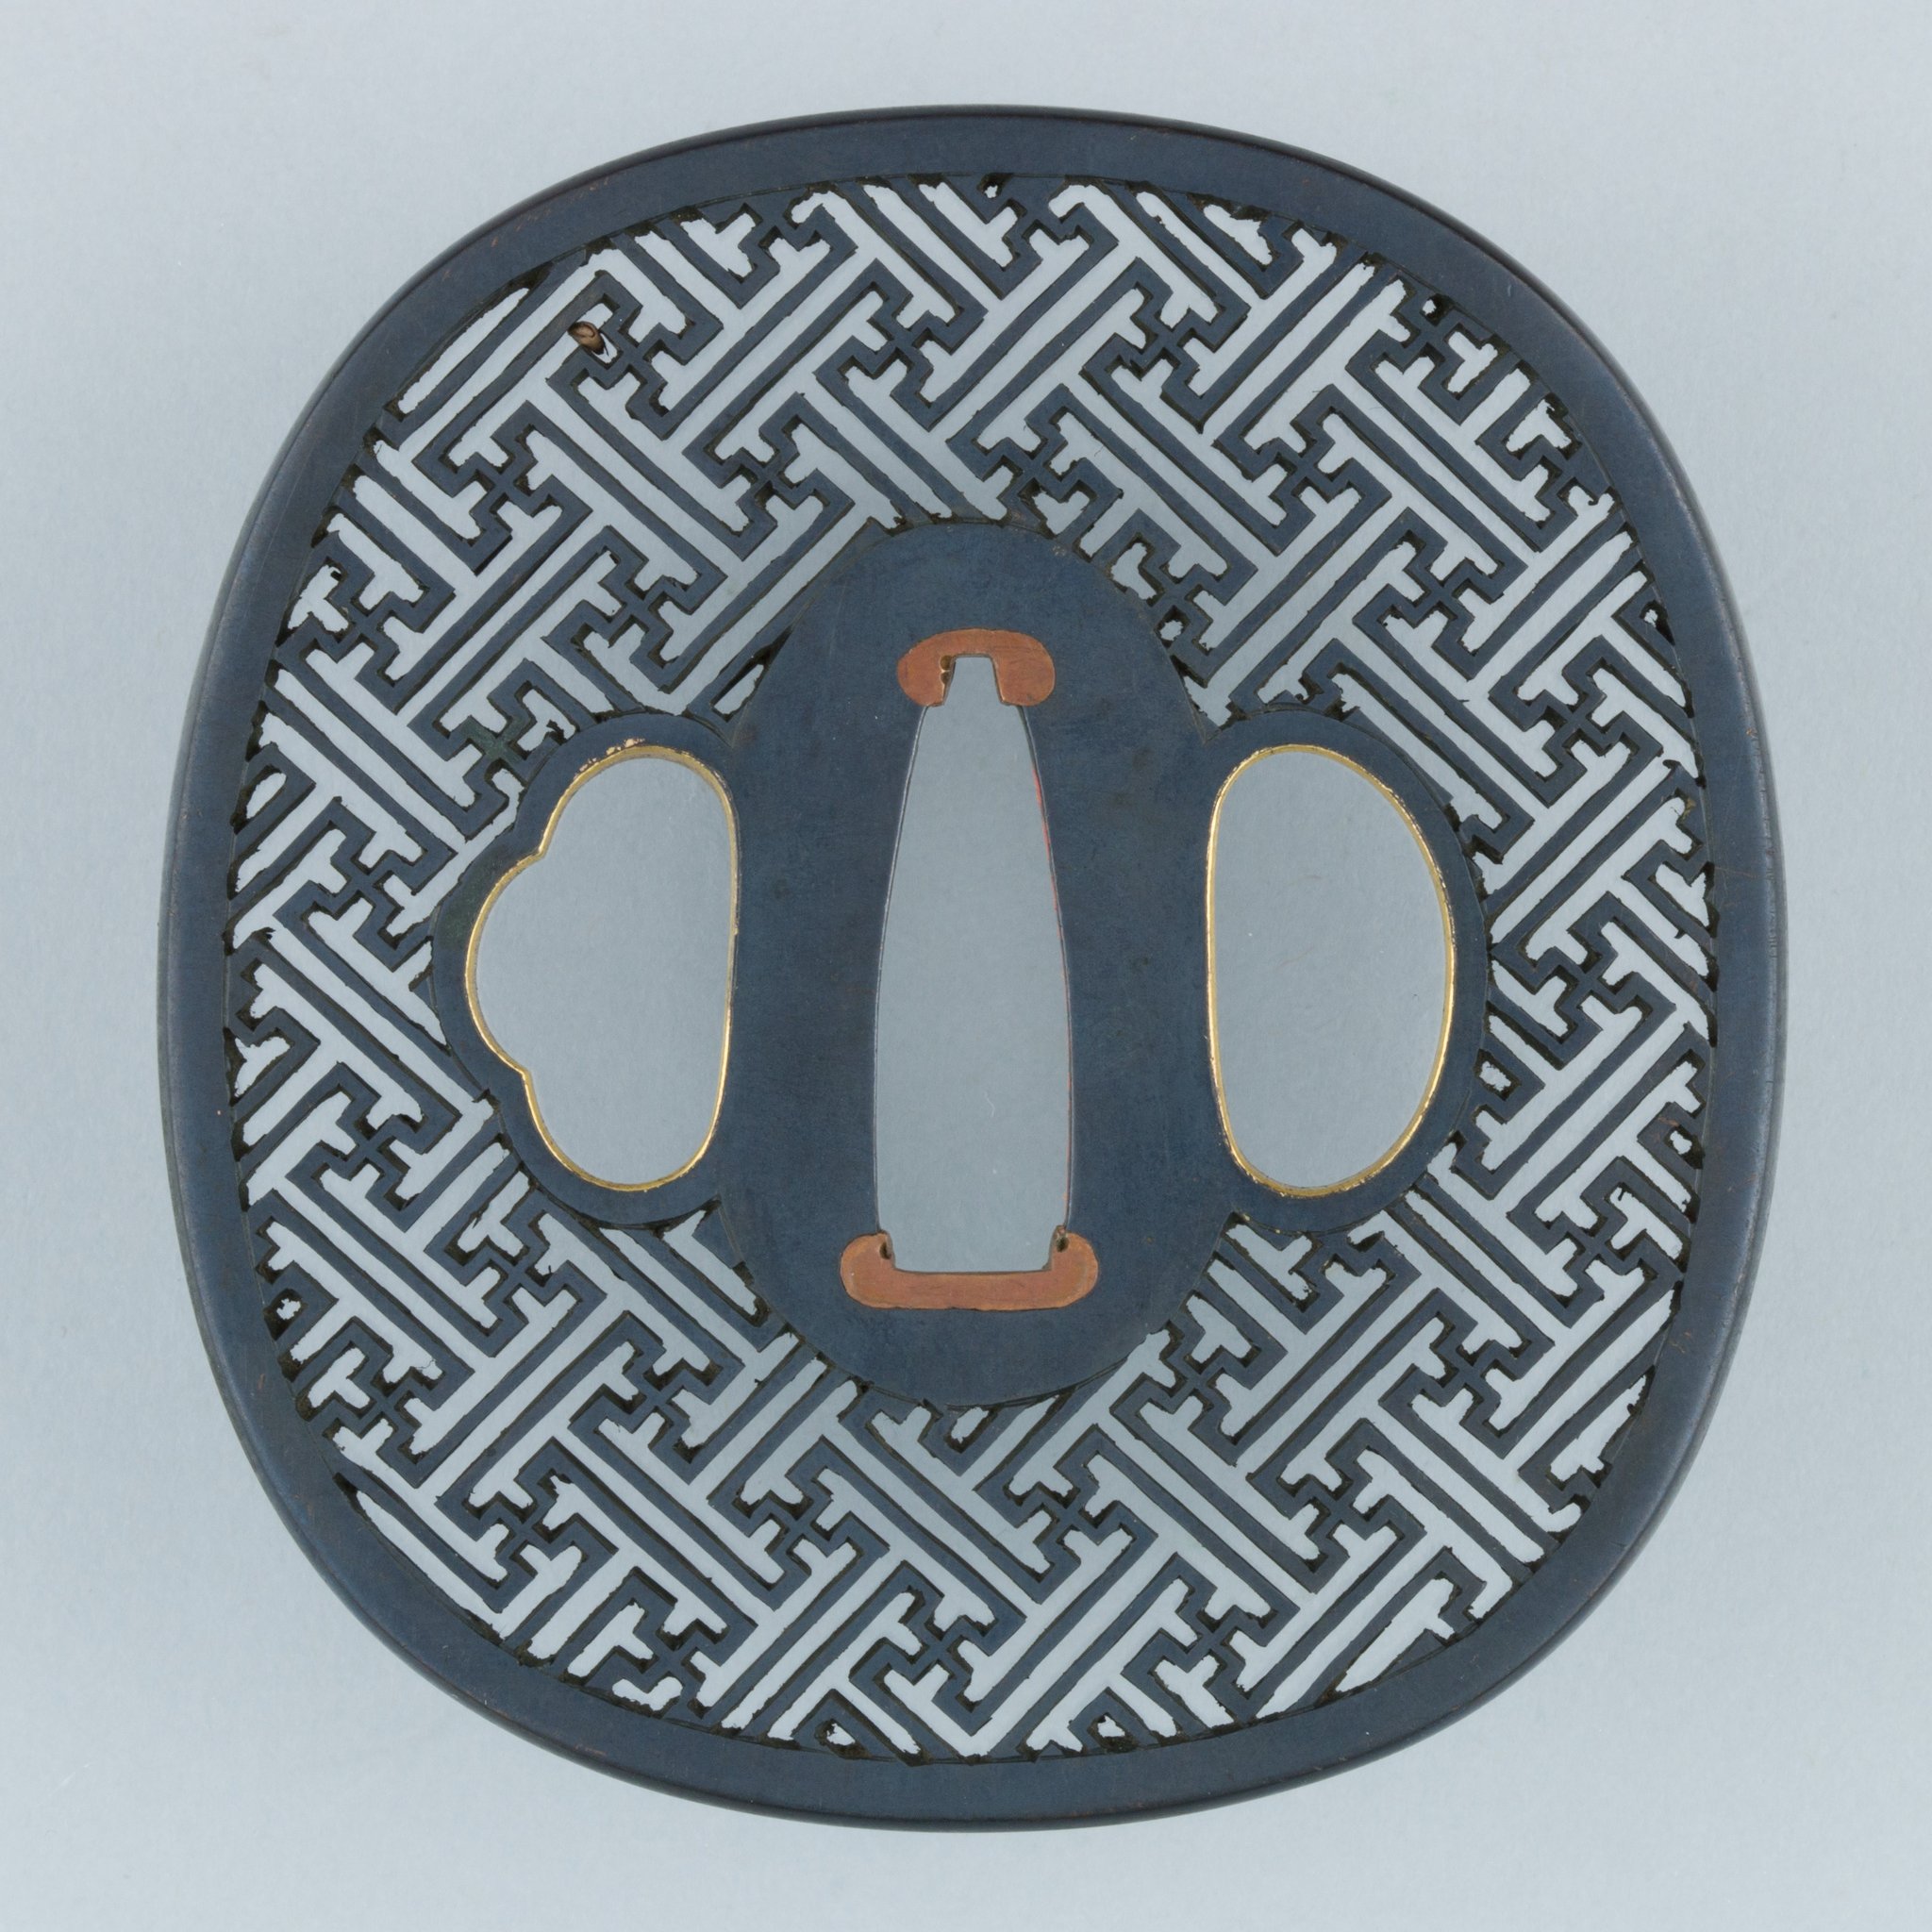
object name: sword guard tsuba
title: Sword Guard (Tsuba)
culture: japanese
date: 1615-1868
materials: copper, gold alloy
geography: japan